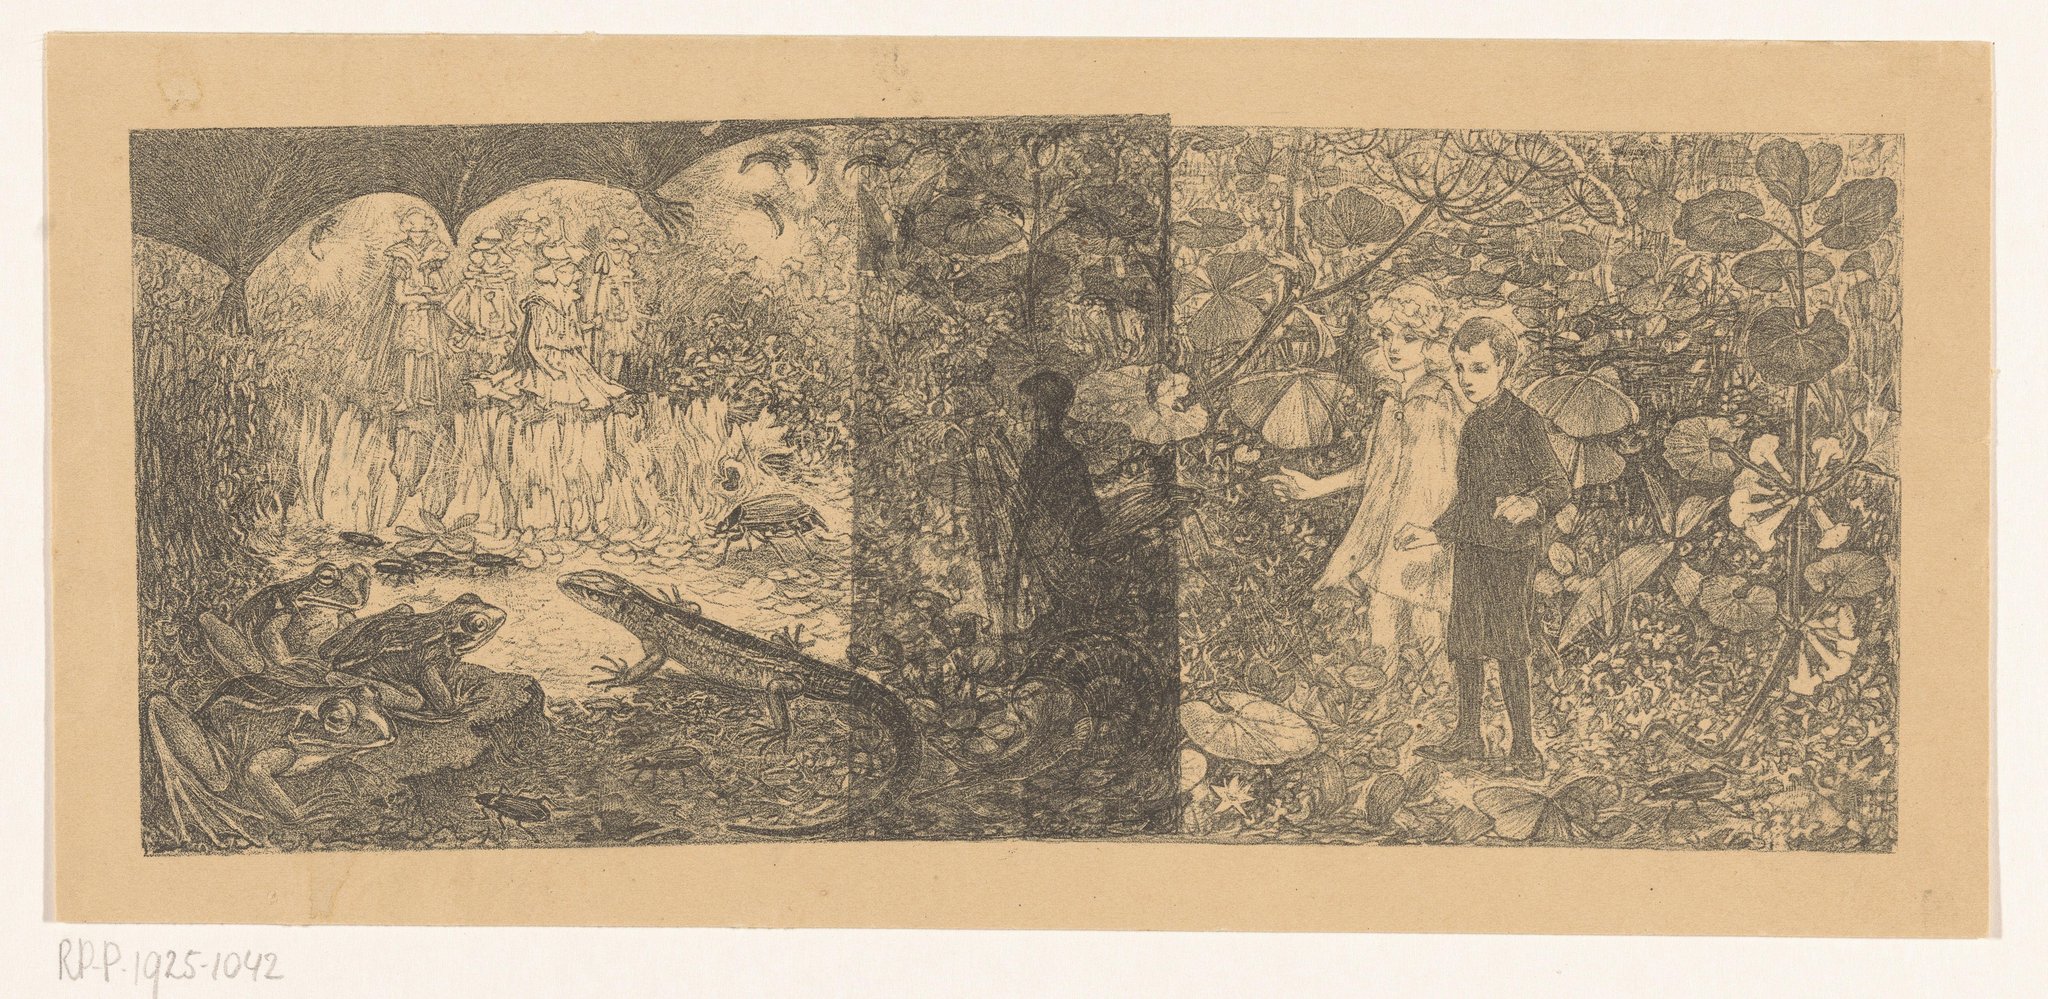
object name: boekillustratie ontwerp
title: Johannes en Windekind bij de elfenkoning Oberon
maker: edzard koning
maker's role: draughtsman, print maker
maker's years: 1869-1954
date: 1879-1925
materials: paper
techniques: lithograph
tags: animals, elf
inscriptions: collector's mark: Lugt 2228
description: Op de voorgrond kikkers, een hagedis, een slak en kevers. Linksboven het onderlijf van een vleermuis. Op de achtergrond zit Oberon op een troon. Hij wordt omringd door andere elfen.